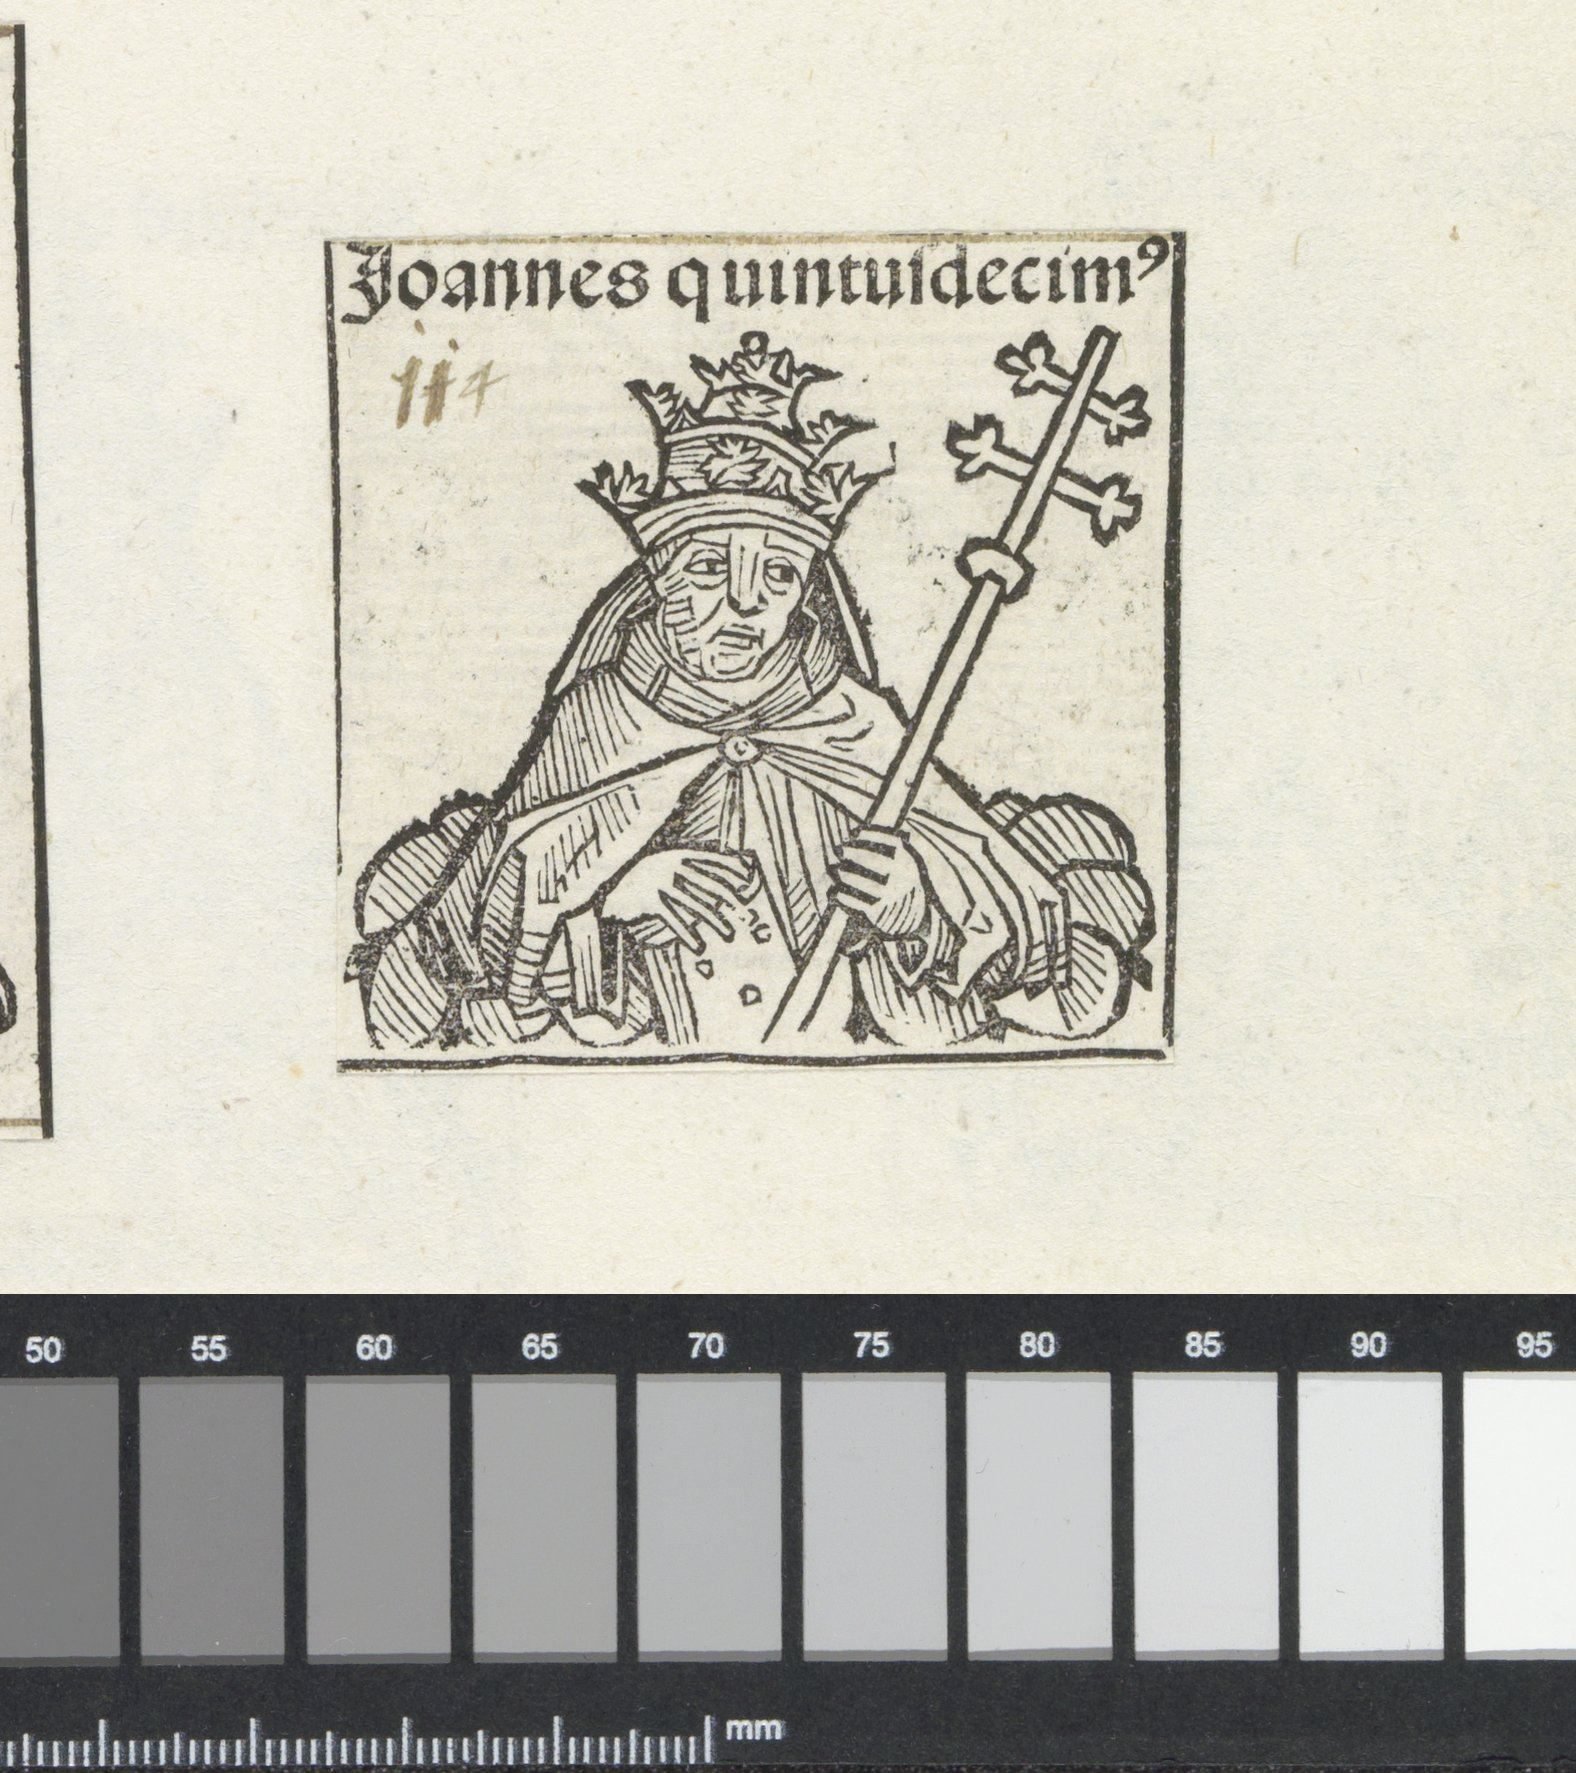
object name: album leaf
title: Liber Chronicarum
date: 1493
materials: paper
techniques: letterpress printing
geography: nuremberg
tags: rome, pope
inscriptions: inscription: ‘114’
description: Een bloemkelk met een paus. Hij draagt een tiara en heeft een bijbel en een staf met een dubbel kruis in zijn handen. De voorstelling is onderdeel van de opeenvolging pausen in de Liber Chronicarum. De tekst identificeert de man als Johannes XV. De prent maakt deel uit van een album.